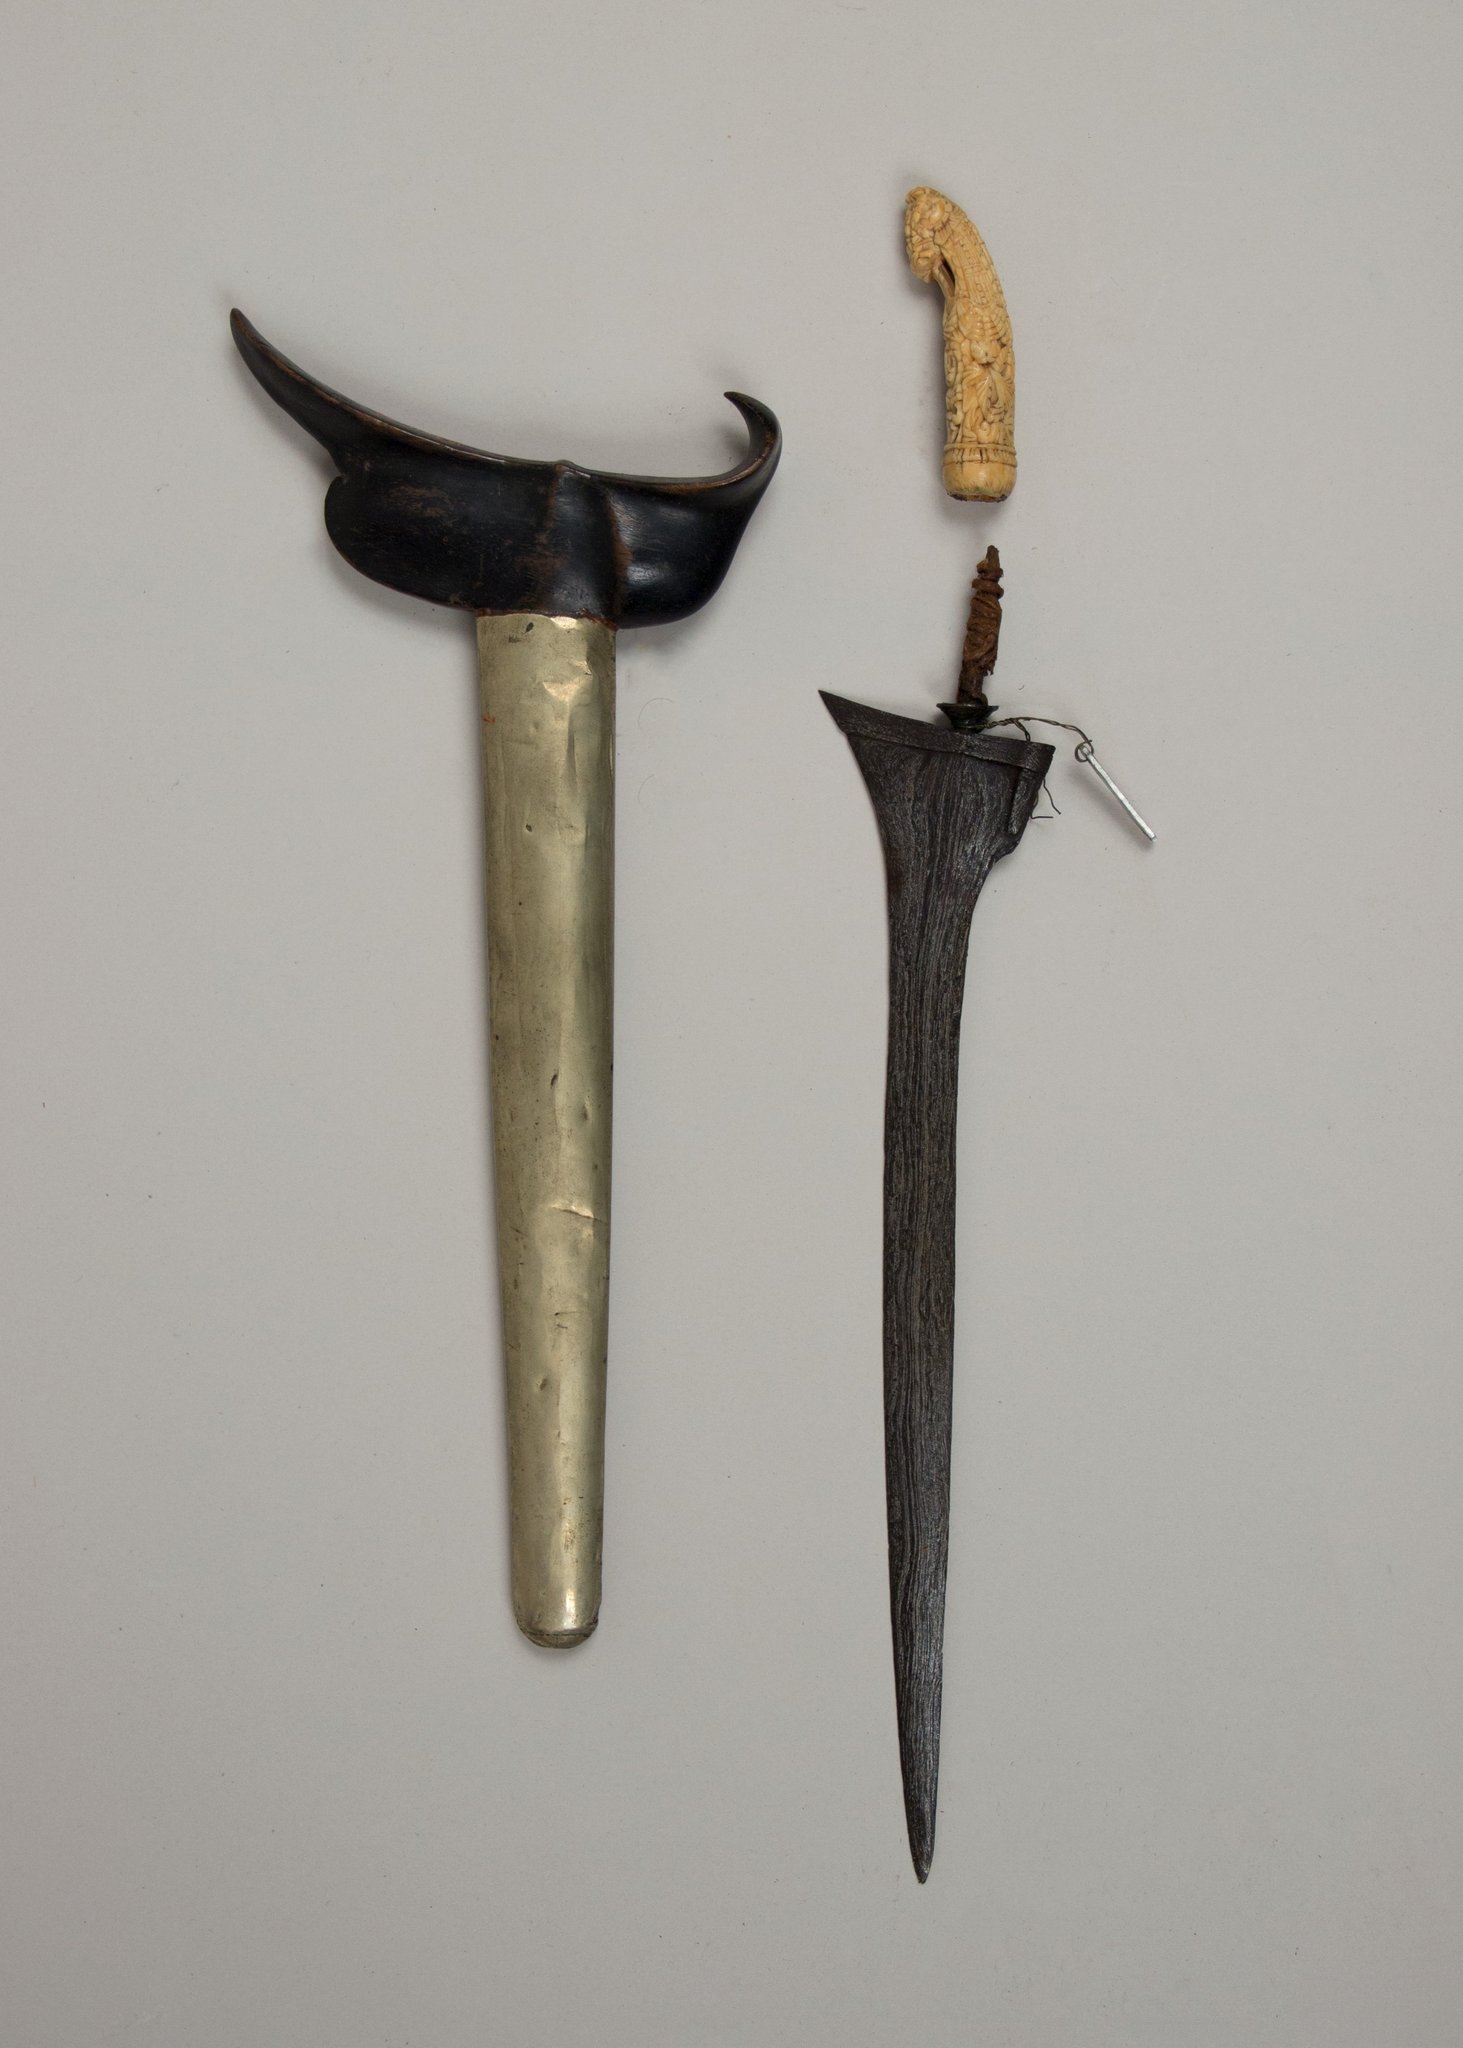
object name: kris with sheath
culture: madurese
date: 1501-1900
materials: ivory, silver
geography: indonesia